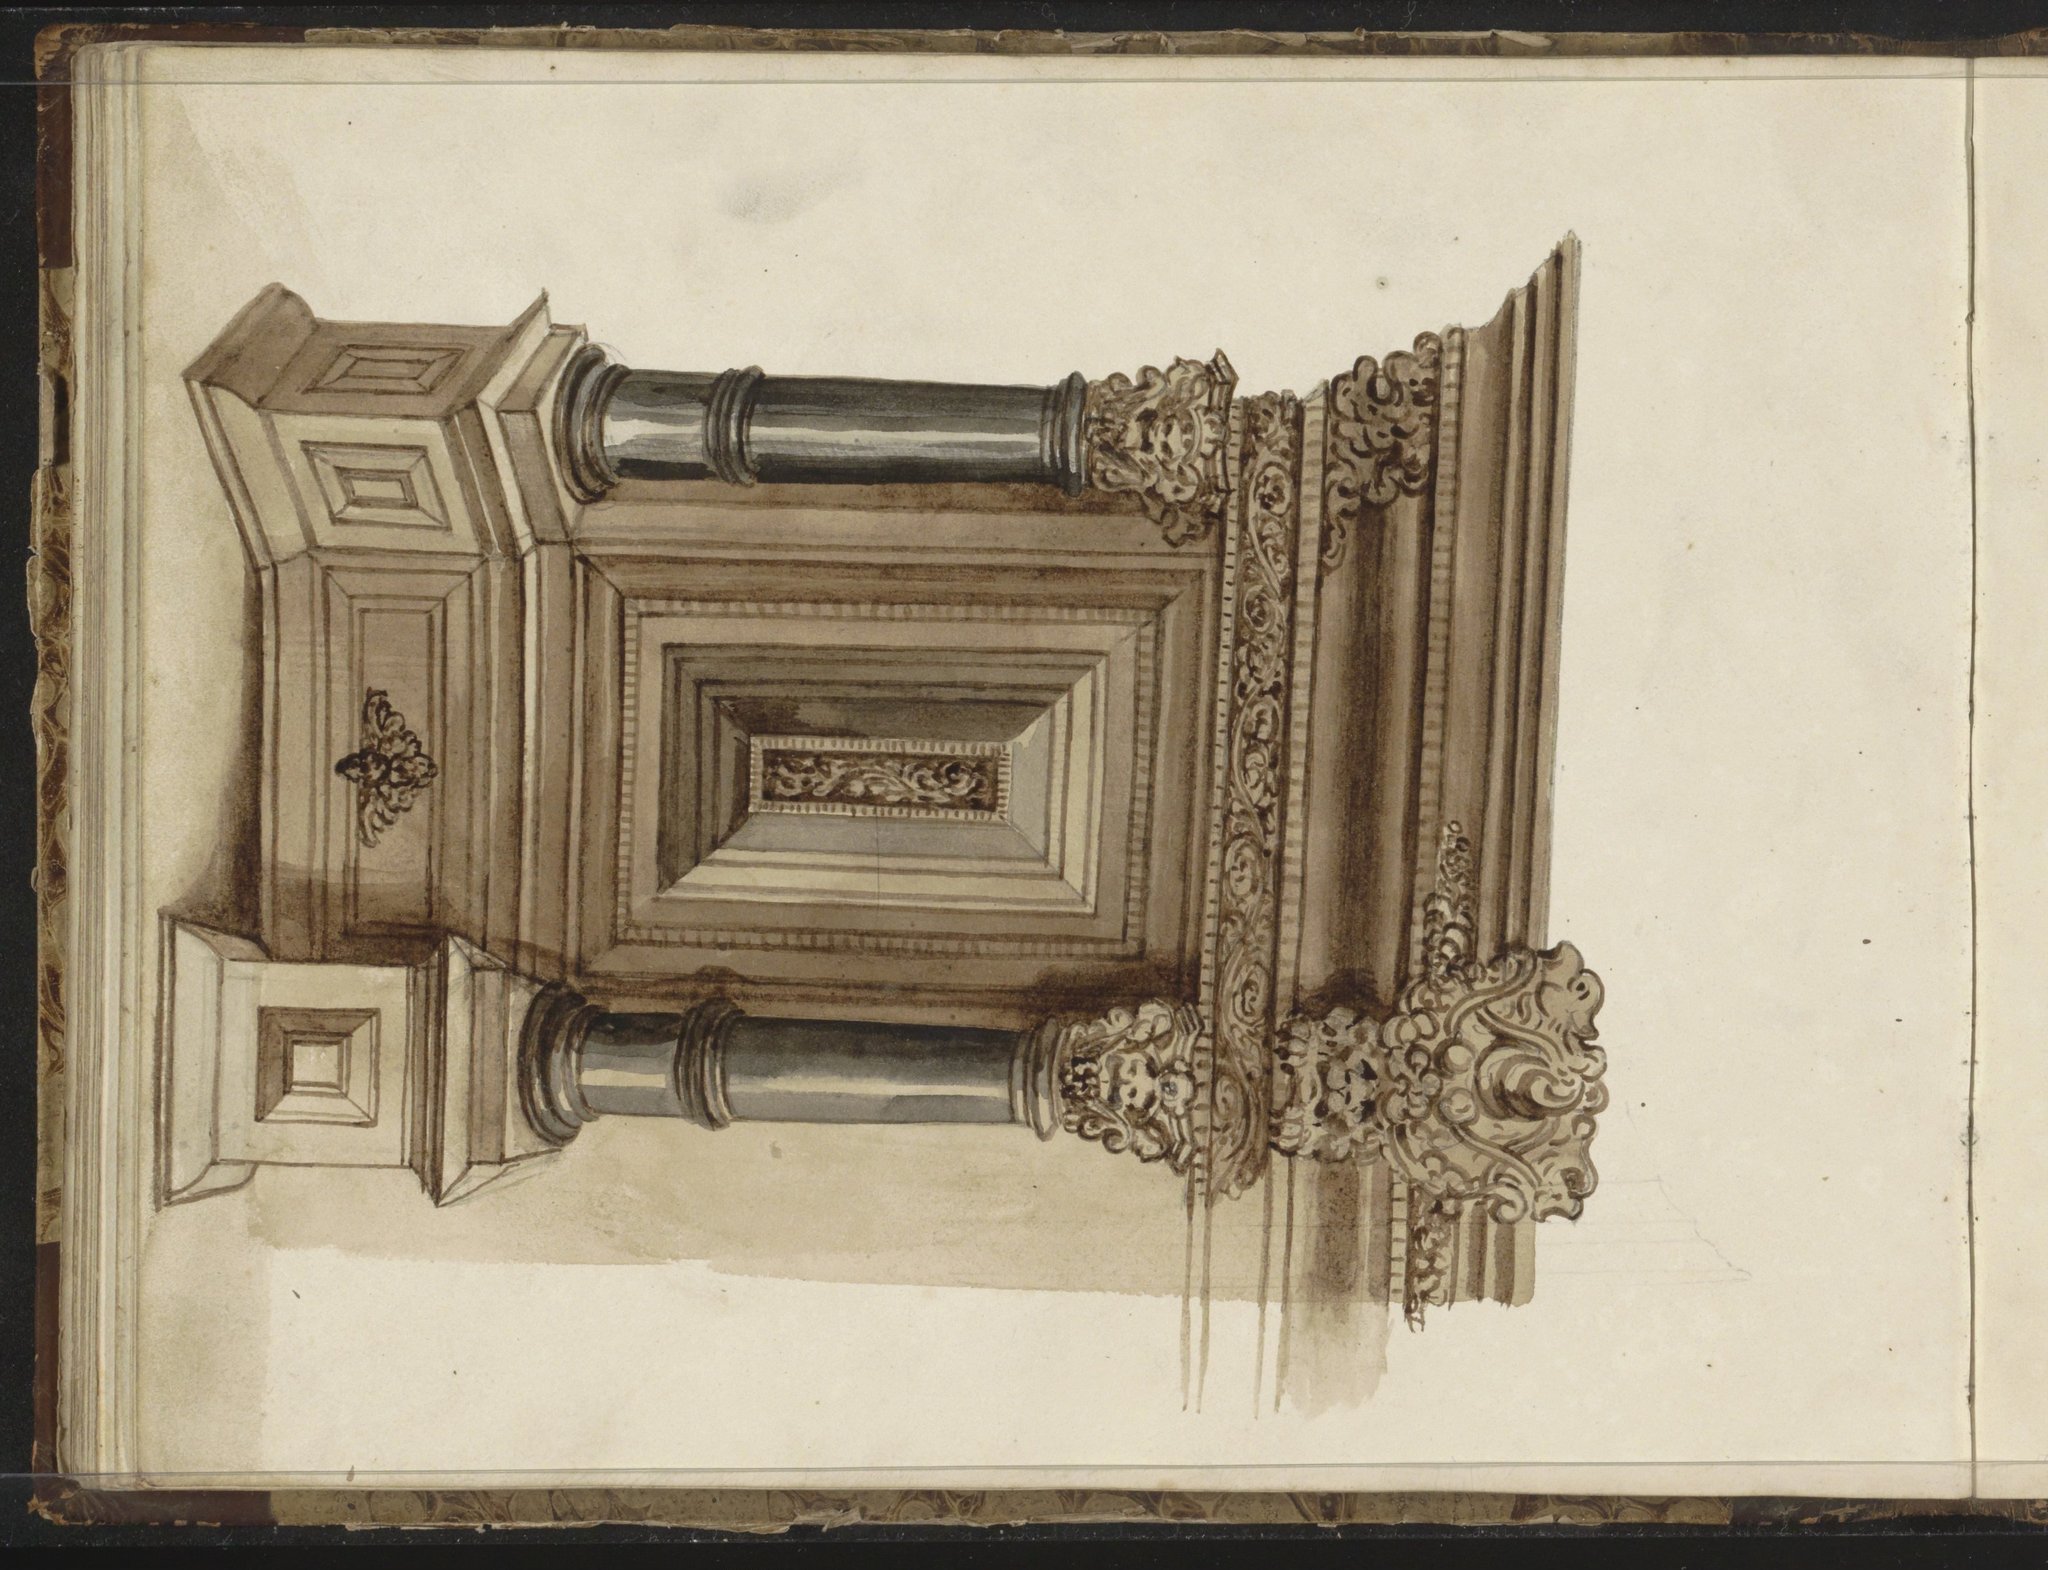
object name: sketchbook leaf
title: Ornamentele wanddecoratie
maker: willem hendrik schmidt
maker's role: draughtsman, painter, print maker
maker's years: 1809-1849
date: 1819-1849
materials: paper, pencil, watercolor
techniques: brush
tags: wall-covering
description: Wanddecoratie met ornamentele panelen, een architraaf en zuilen. Blad 38 verso uit een schetsboek met 52 bladen.